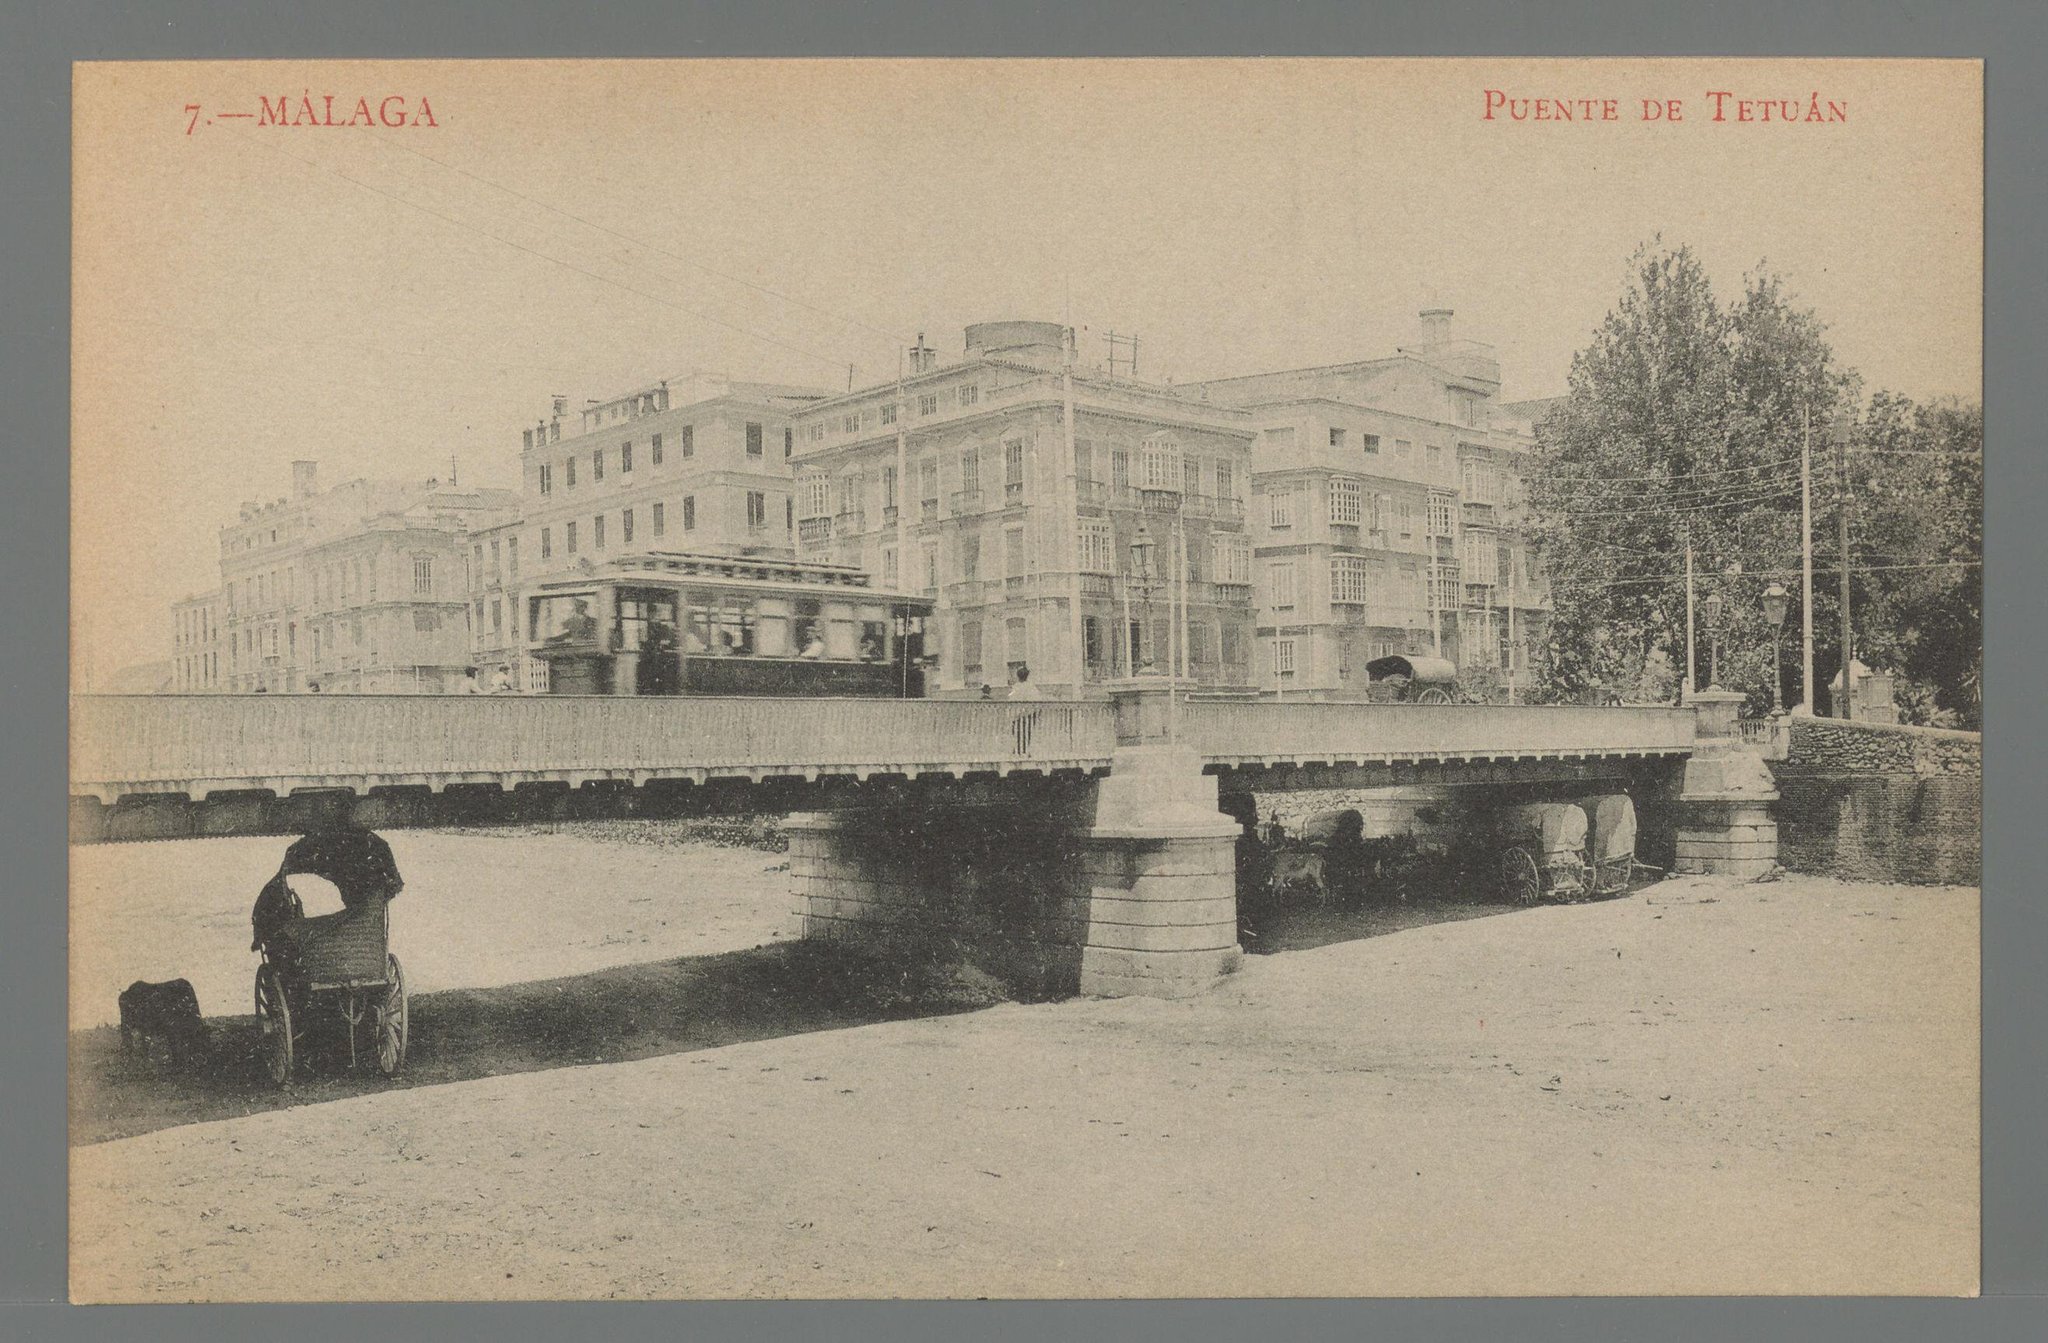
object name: ansichtkaart, prentbriefkaart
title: Málaga. Puente de Tetuán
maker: Anonymous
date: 1906-1930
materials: cardboard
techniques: photograph, writing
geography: barcelona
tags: bridge in city across river, canal, etc.